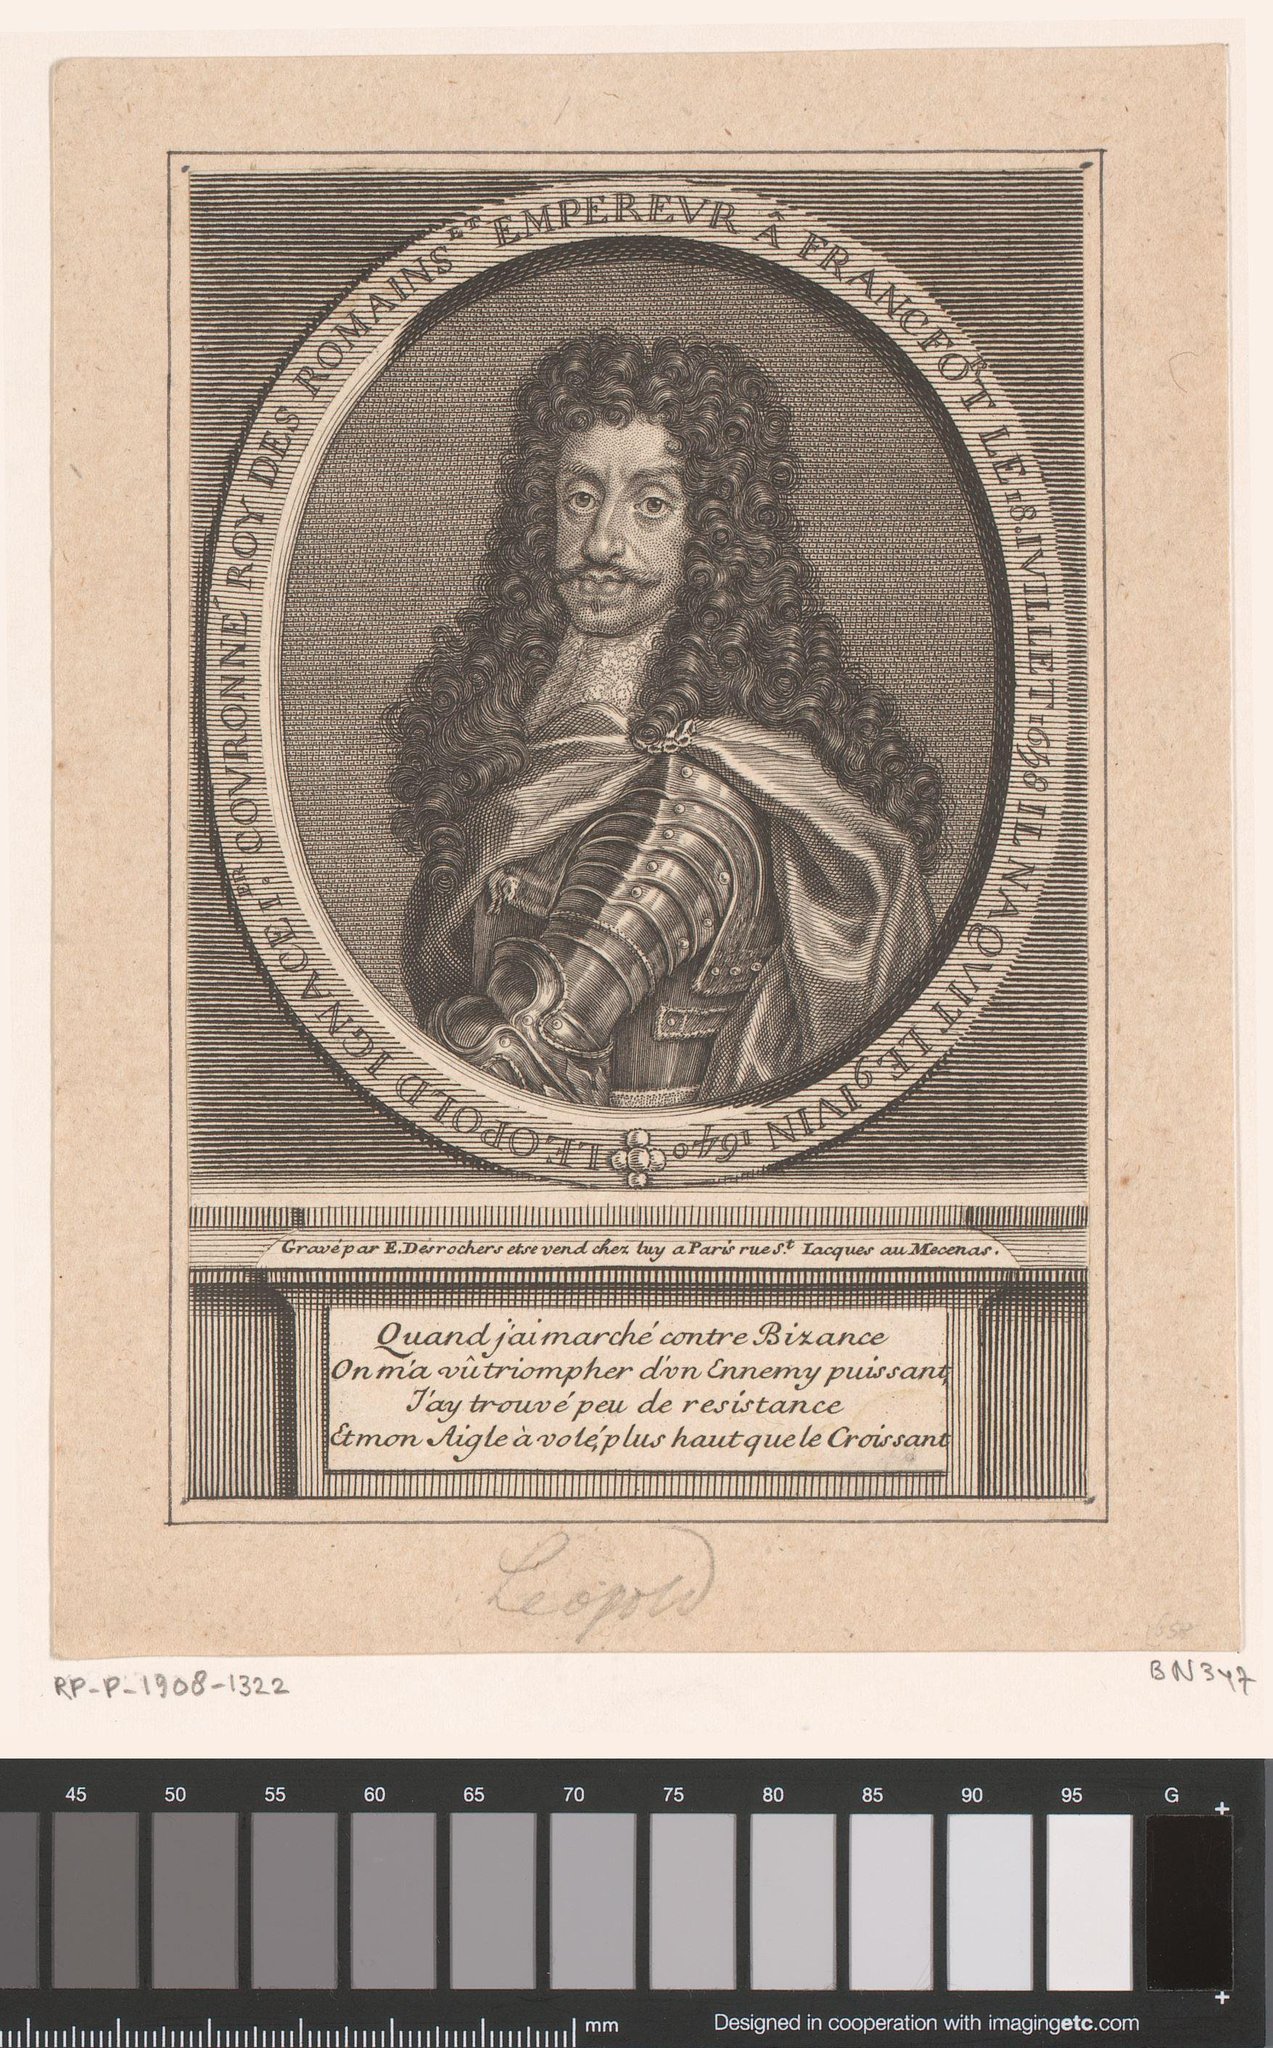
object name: print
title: Portret van keizer Leopold I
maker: étienne desrochers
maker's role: print maker, publisher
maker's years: 1668-1741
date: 1726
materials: paper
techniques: engraving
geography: paris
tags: leopold i (keizer van duitsland), historical persons, emperor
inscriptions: collector's mark: Lugt 2228, number: ‘No. 4.’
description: Behoort waarschijnlijk tot een serie portretten, grotendeels door Etienne Desrochers, getiteld: 'Recueil de portraits de personnes qui se sont distinguées tant dans les Armes que dans Belles-Lettres et les Arts, comme aussi la famille royale de France et autres cours étrangères'. De serie werd initieel uitgegeven door Desrochers en aangekondigd in 'Mercure' in mei 1726, p. 985. Echter was Desrochers reeds enkele jaren eerder begonnen met het uitgeven van de serie. Na de dood van Desrochers werd de serie voortgezet door Gilles Edme Petit. Een latere staat werd uitgegeven door Jean François Daumont in Parijs.